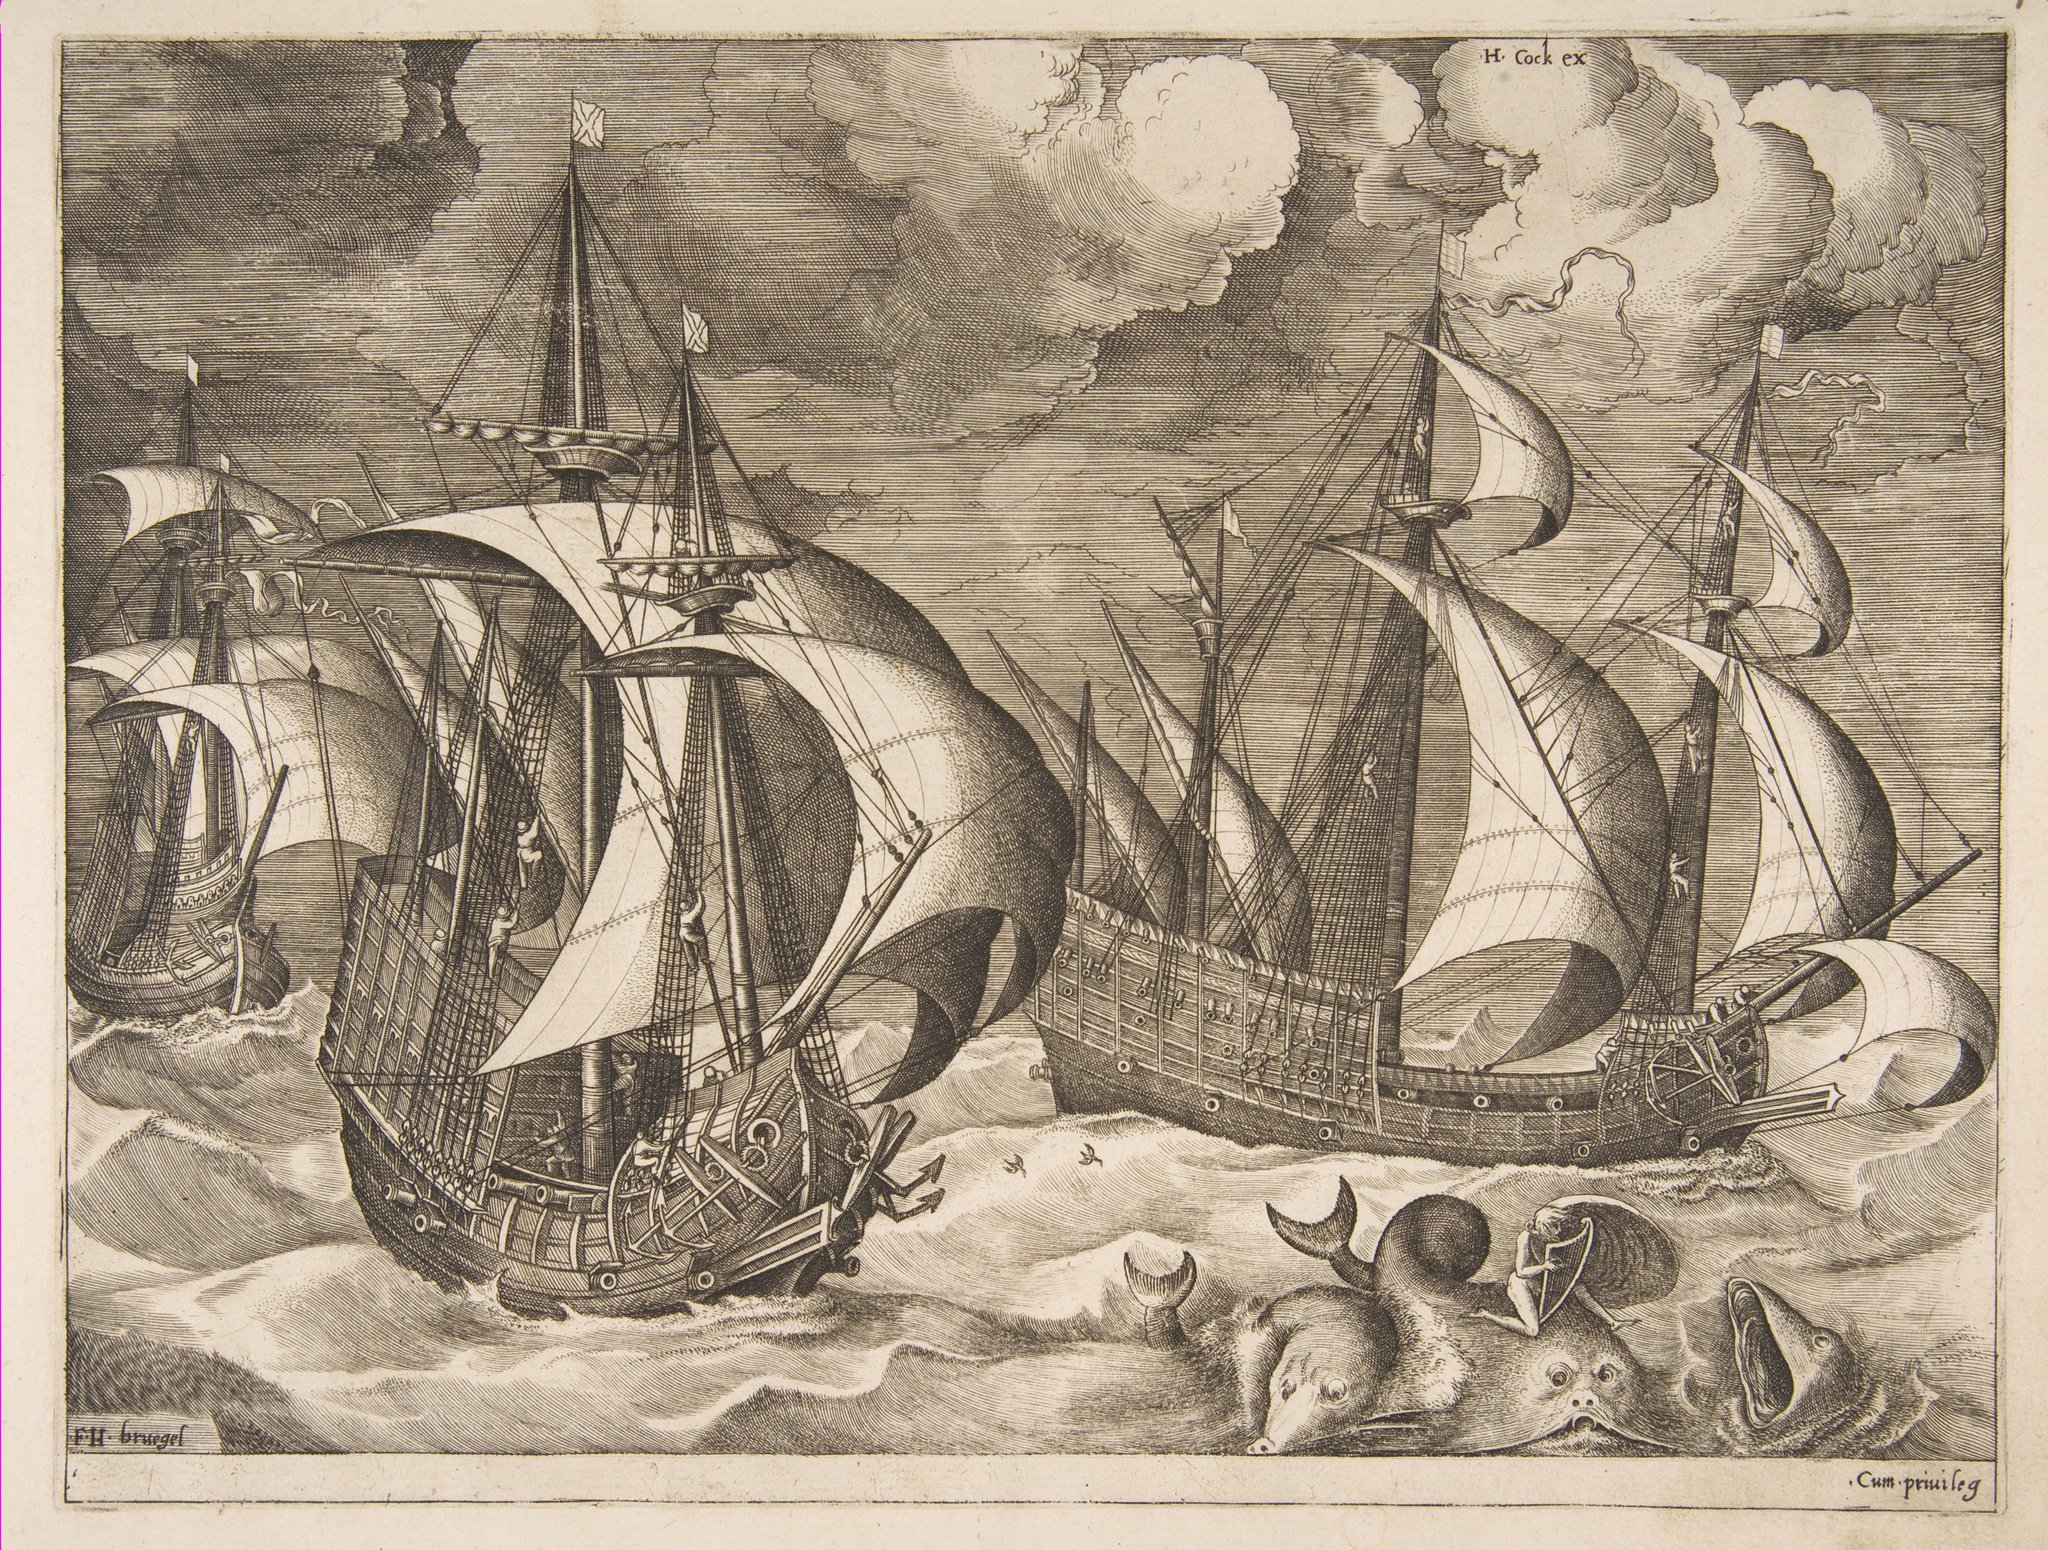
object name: print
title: Three Caravels in a Rising Squall with Arion on a Dolphin from The Sailing Vessels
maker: pieter bruegel the elder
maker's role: artist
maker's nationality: netherlandish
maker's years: 1525-1569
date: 1561-1565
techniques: engraving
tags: human figures,musical instruments,dolphins,waves,ships